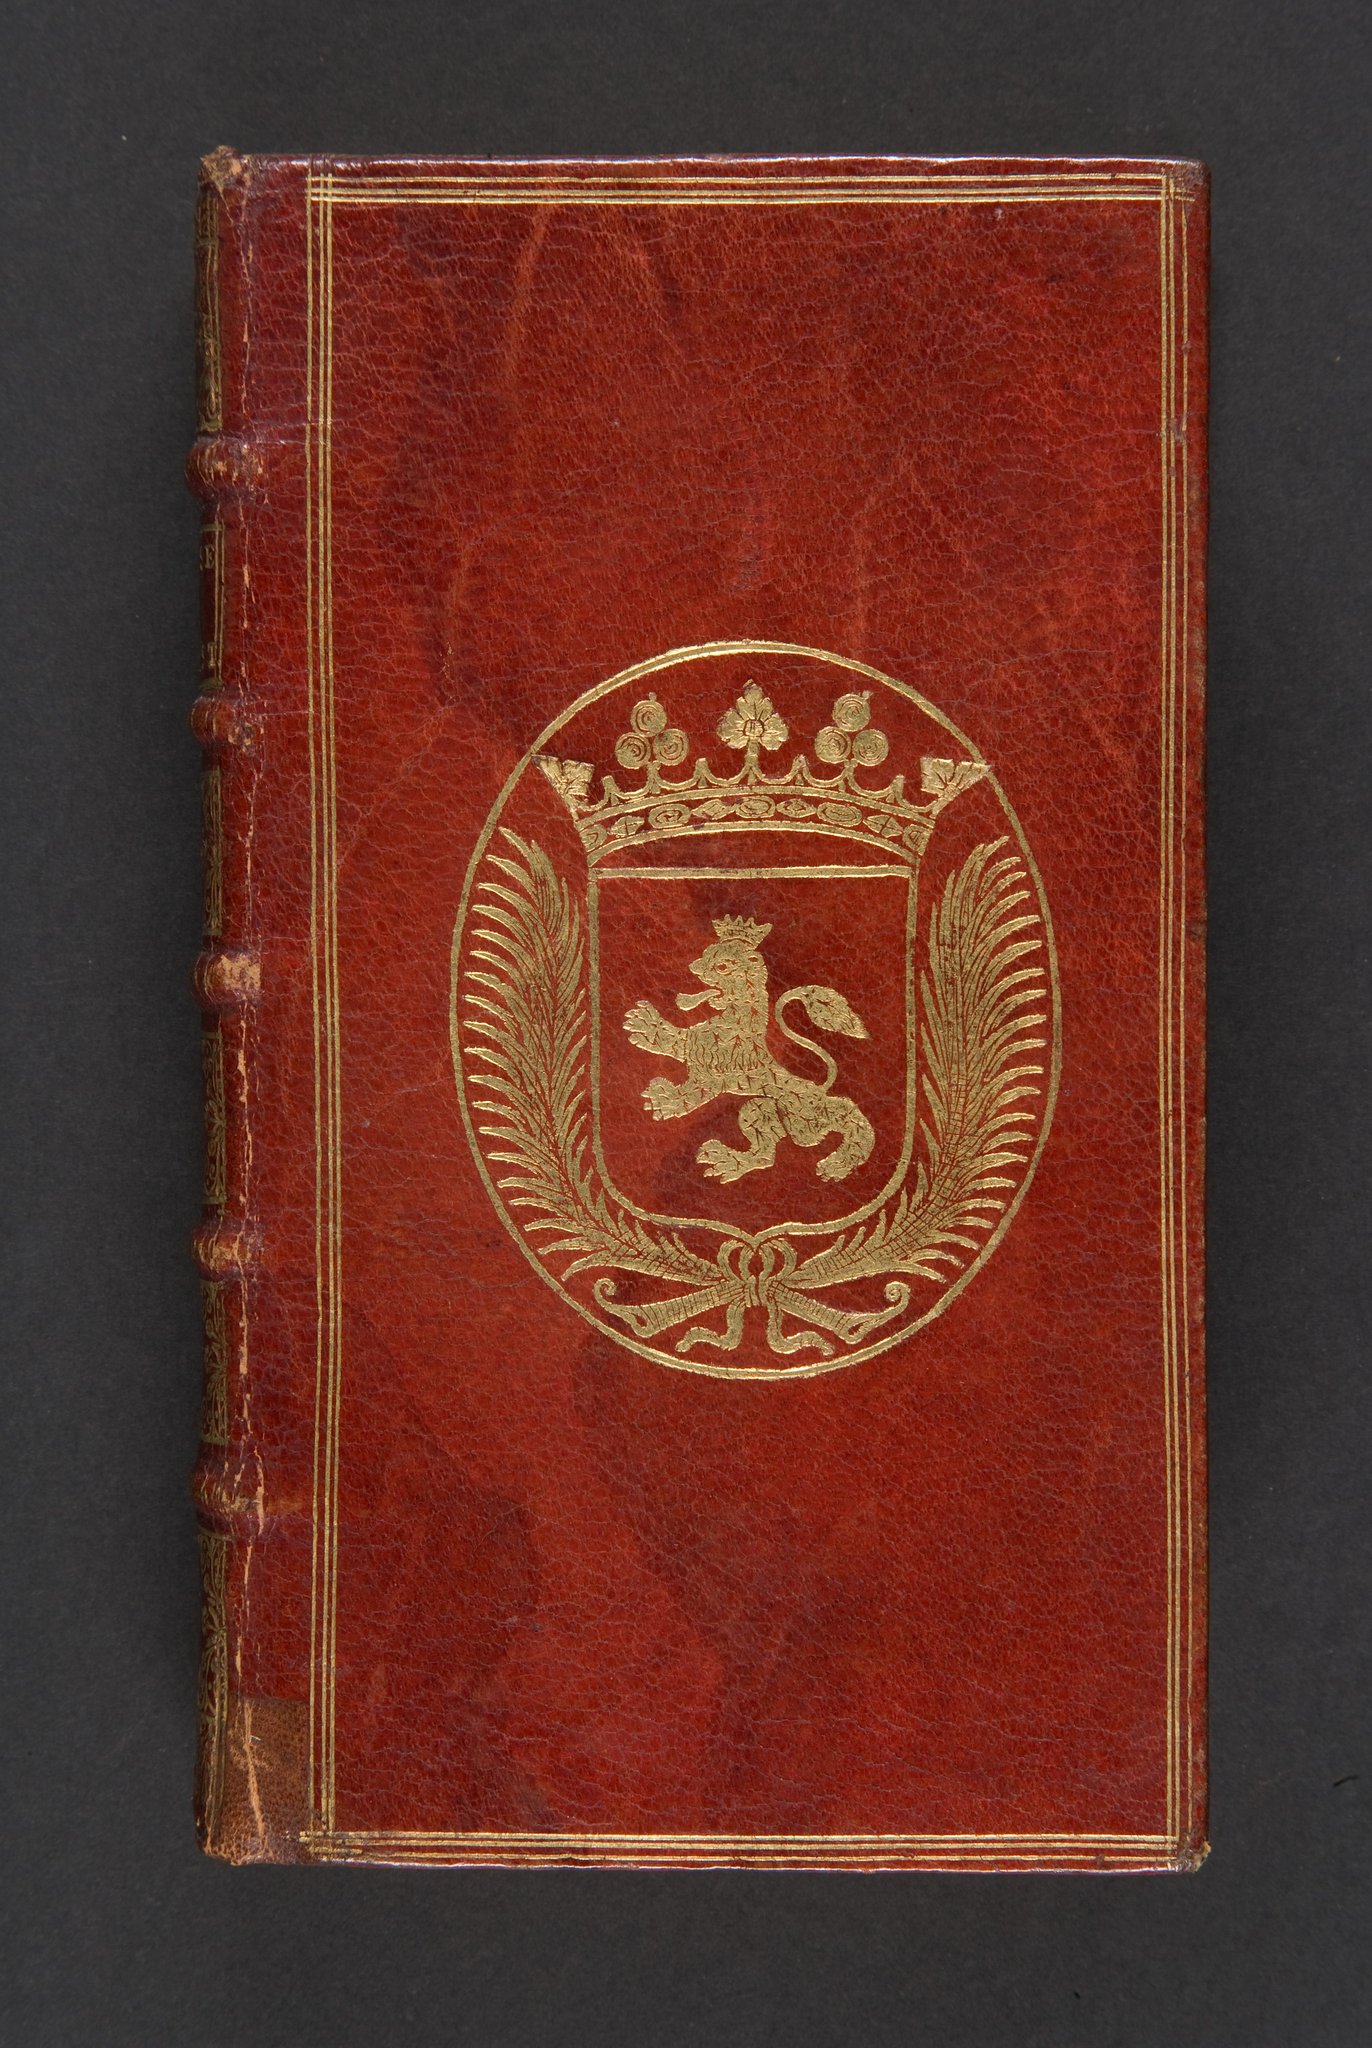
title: Réponse aux plaintes des protestans touchant la prétendüe persecution de France. : Où l'on expose le sentiment de Calvin, & de tous les plus célebres ministres, sur les peines dûës aux hérétiques. On découves aussi plusieurs particularitez dignes d'être sçûës, touchant la Réformation & les réformateurs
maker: denis de sainte-marthe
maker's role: author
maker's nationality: french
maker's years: 1650-1725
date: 1688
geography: france